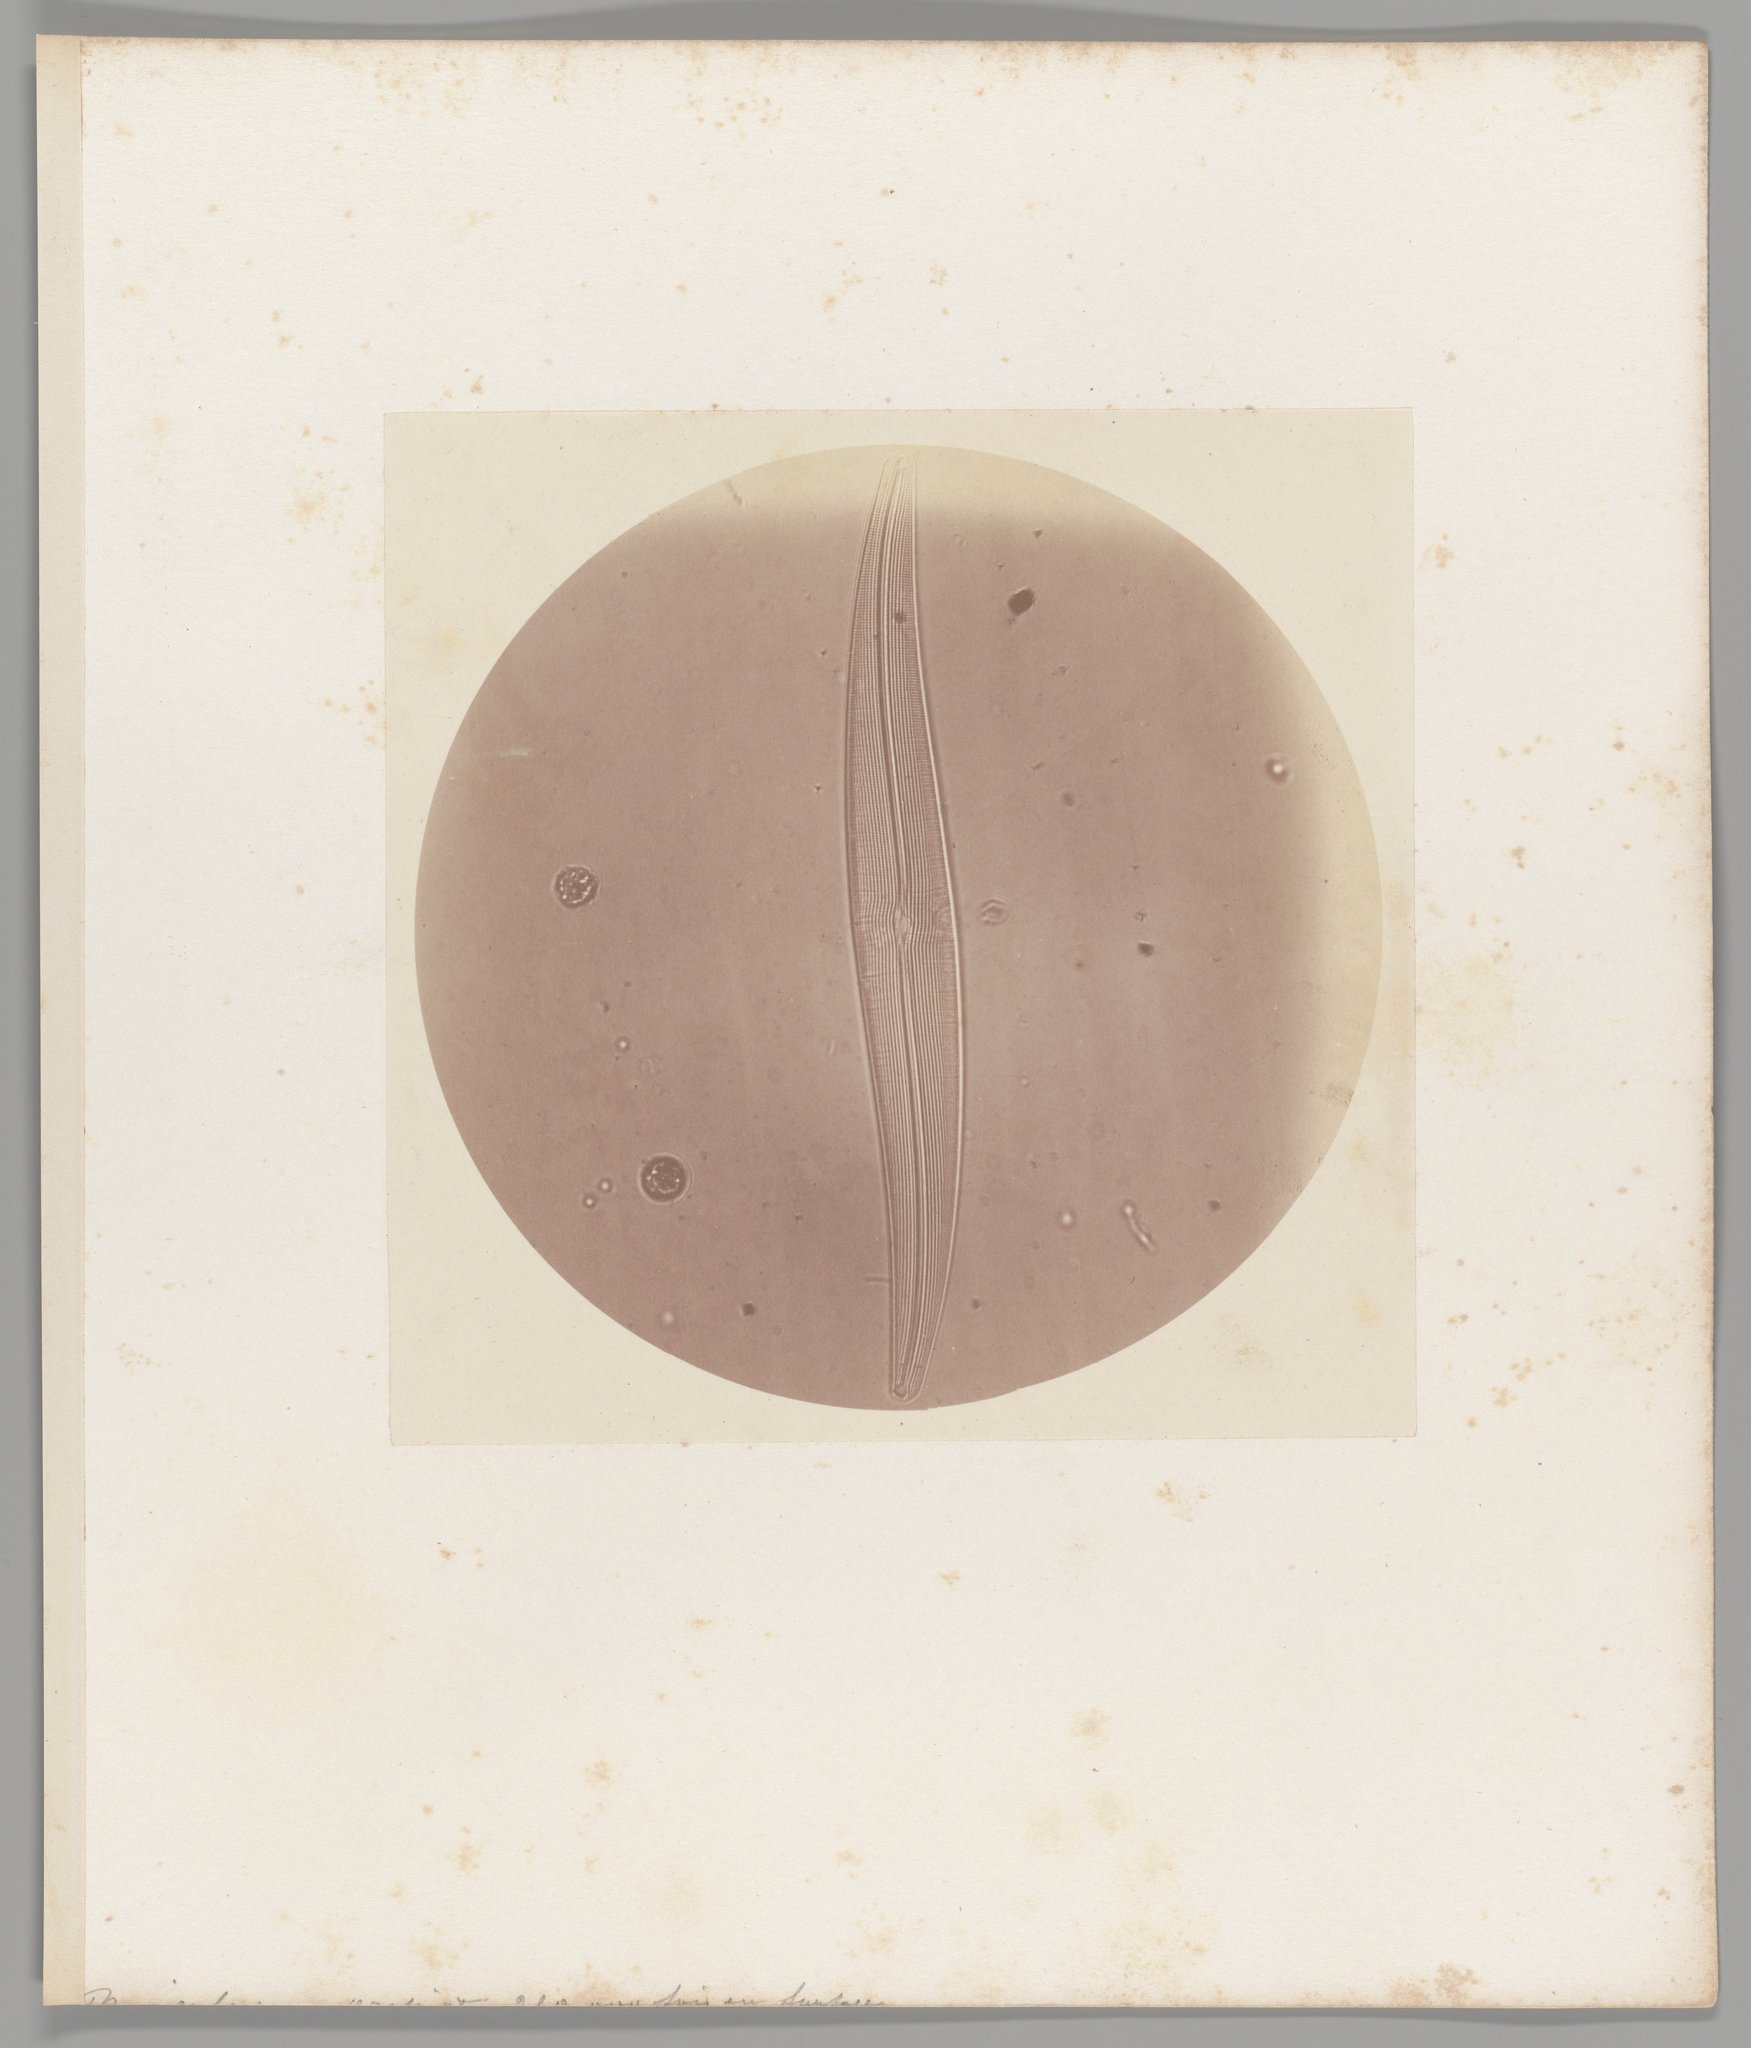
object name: photograph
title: [Untitled]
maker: auguste-adolphe bertsch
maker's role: artist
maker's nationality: french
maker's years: 1813-1871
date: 1853-1857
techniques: salted paper print